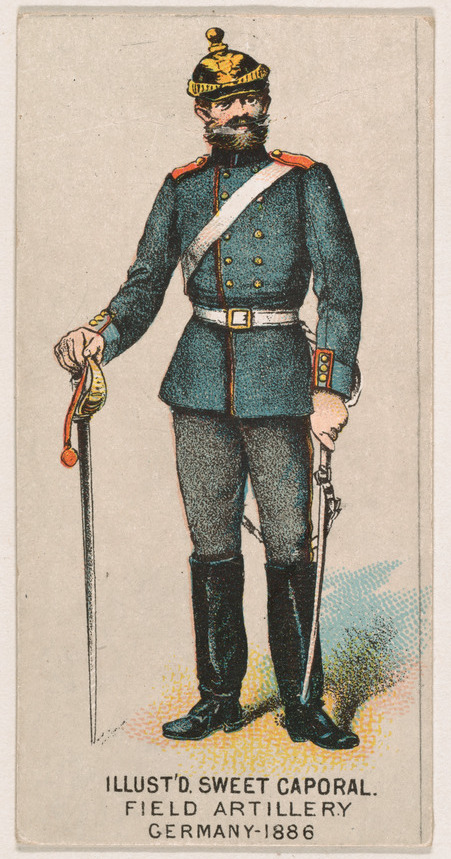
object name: print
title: Field Artillery, Germany, 1886, from the Military Series (N224) issued by Kinney Tobacco Company to promote Sweet Caporal Cigarettes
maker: kinney brothers tobacco company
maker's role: publisher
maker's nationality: american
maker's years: 1869-2011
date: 1888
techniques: color lithograph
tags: military,men